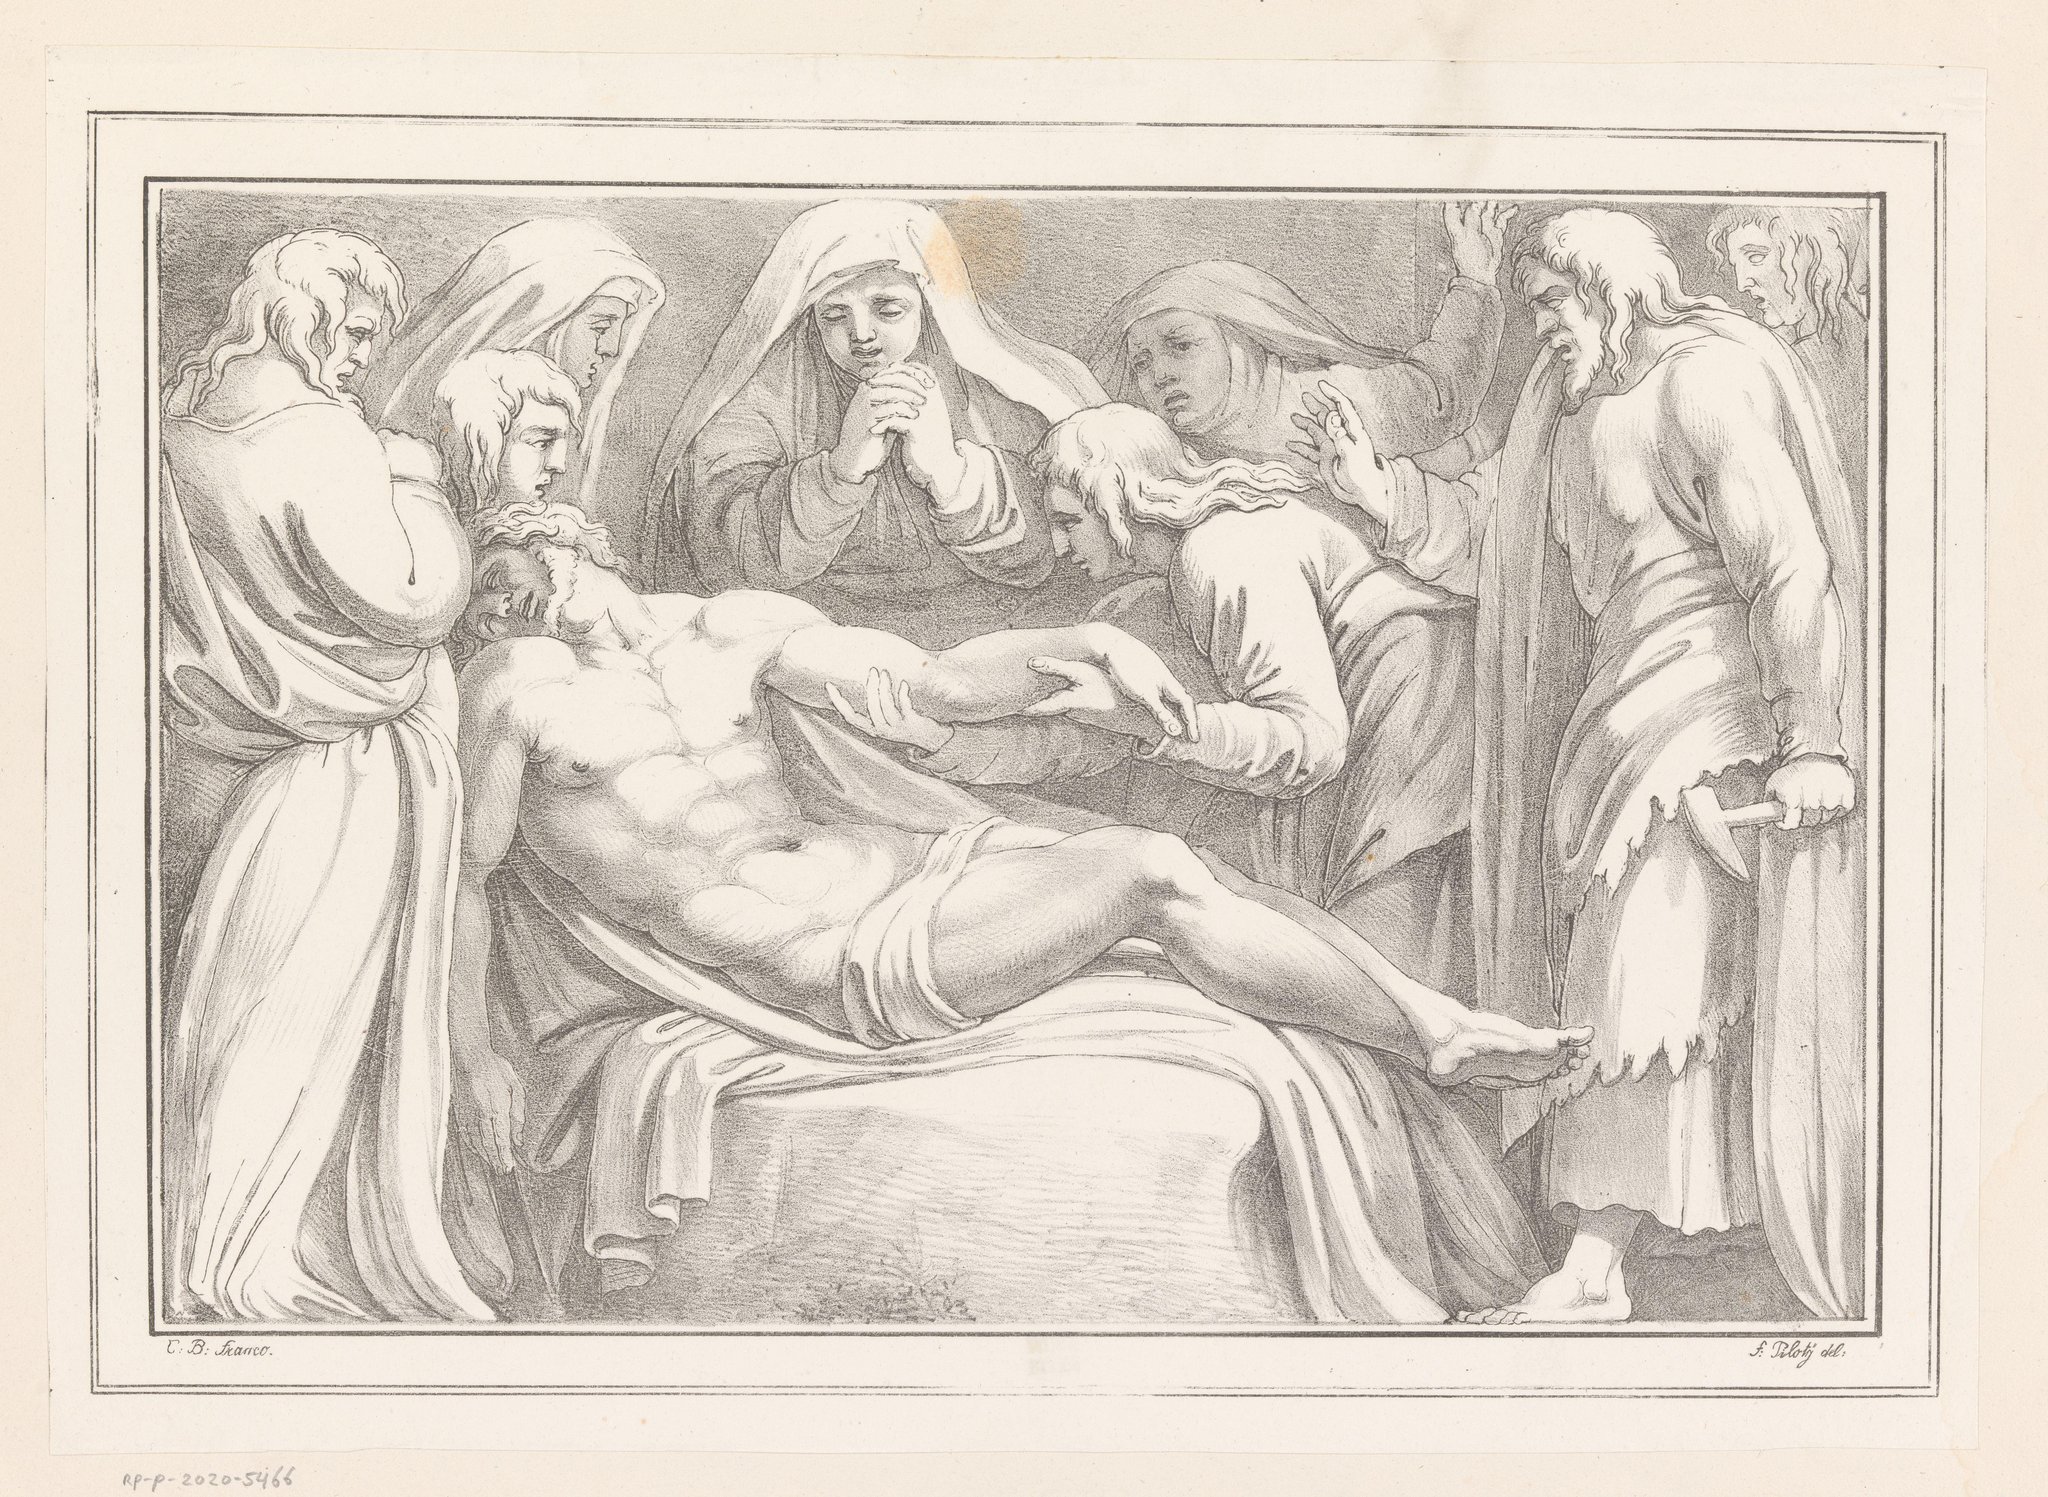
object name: print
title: Lithografieën naar werk uit de collectie van Maximiliaan I Jozef van Beieren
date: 1816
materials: paper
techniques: lithograph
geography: munich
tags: lamentation over the dead christ by his relatives and friends (christ usually without crown of thorns)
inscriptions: collector's mark: Lugt 2166